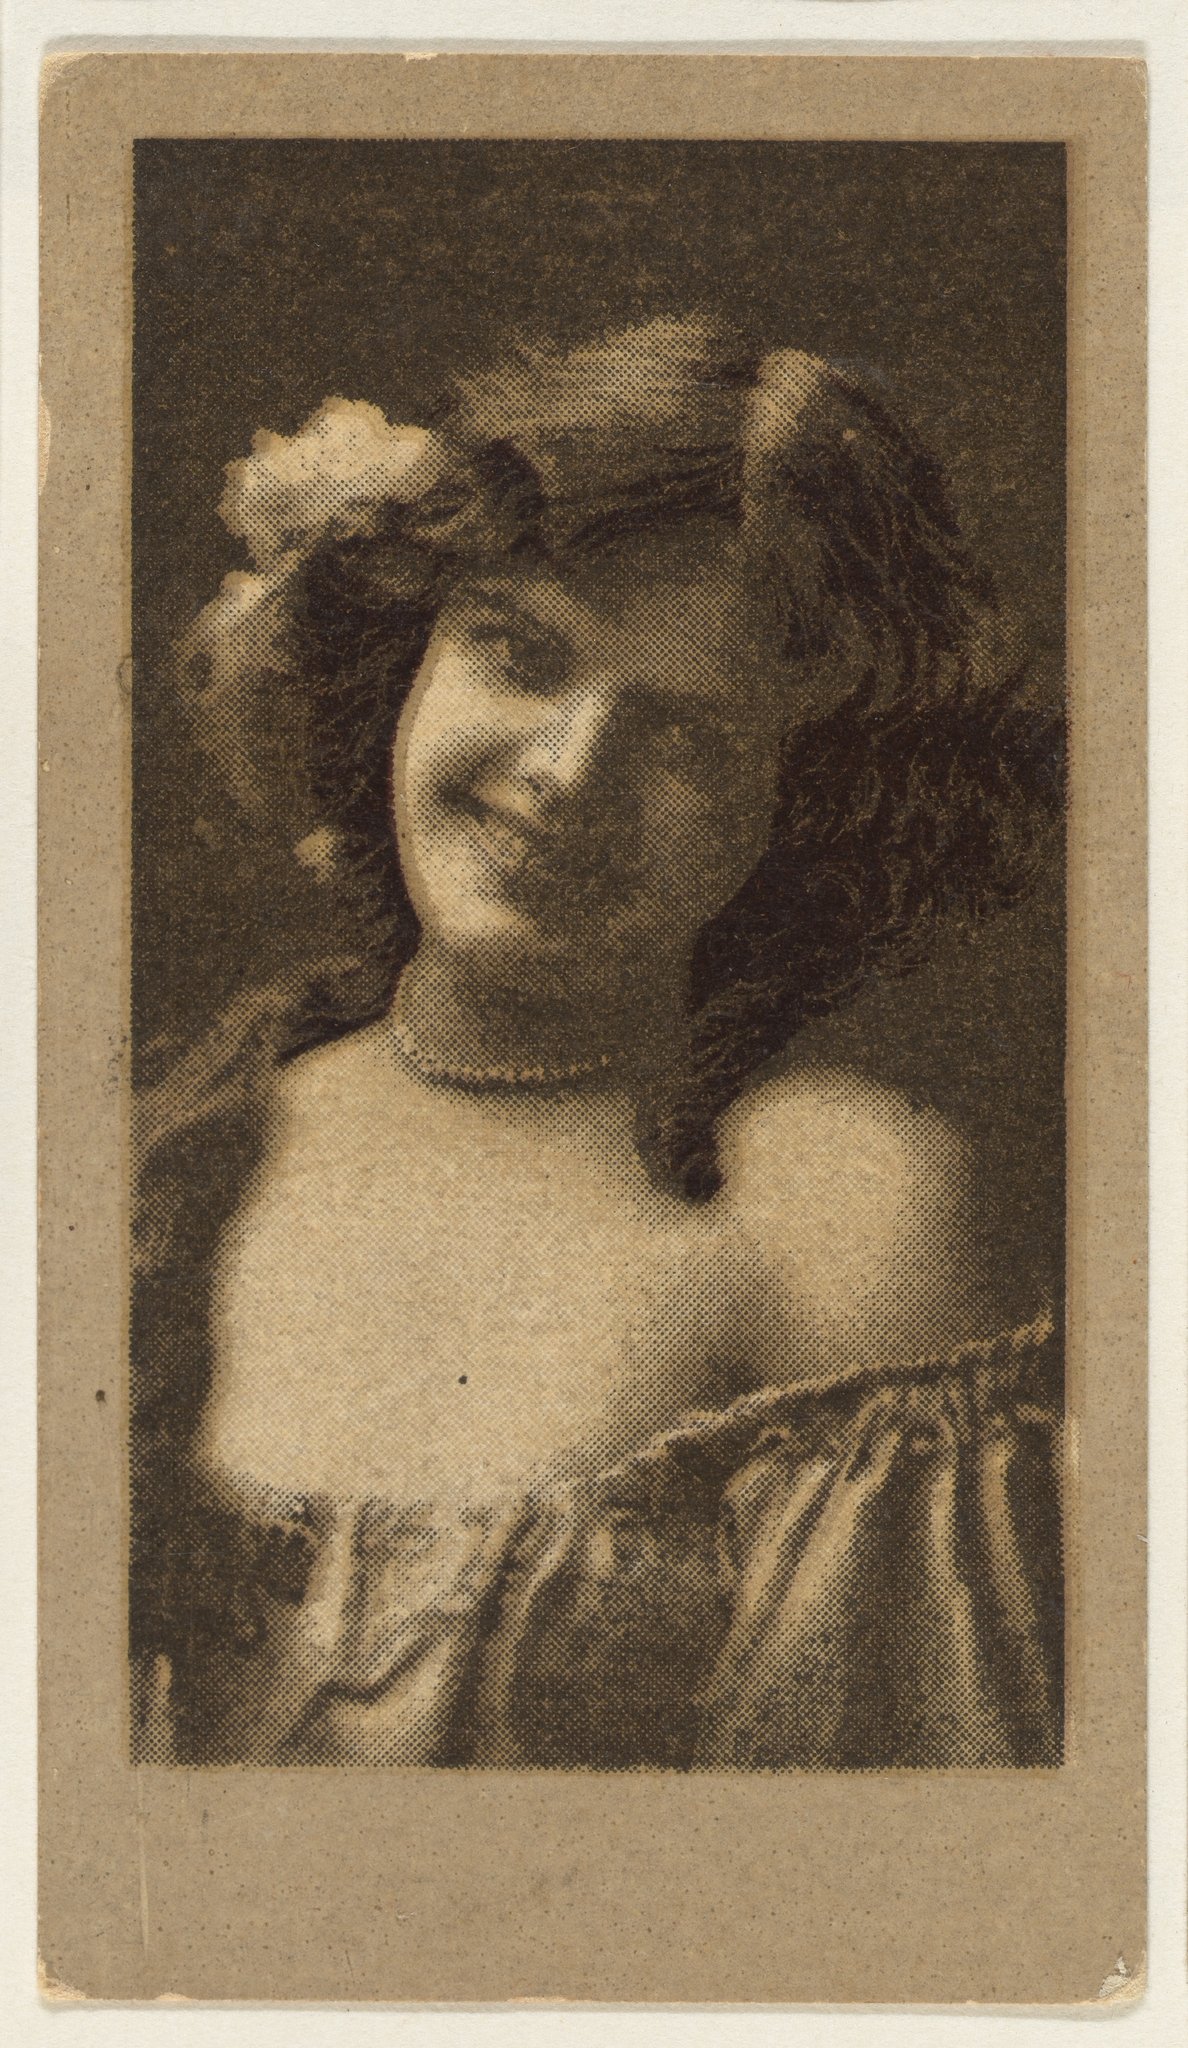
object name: print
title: Portrait of a smiling woman, from the "Girls" series (T66), issued with Hunter Dog Cigarros by S. Monday & Sons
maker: s. monday & sons, brooklyn, new york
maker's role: publisher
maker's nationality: american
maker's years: 1850-1950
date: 1900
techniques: photolithograph